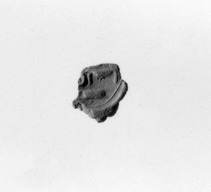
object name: sealing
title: Document Sealing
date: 1390-1352 BCE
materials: mud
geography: egypt